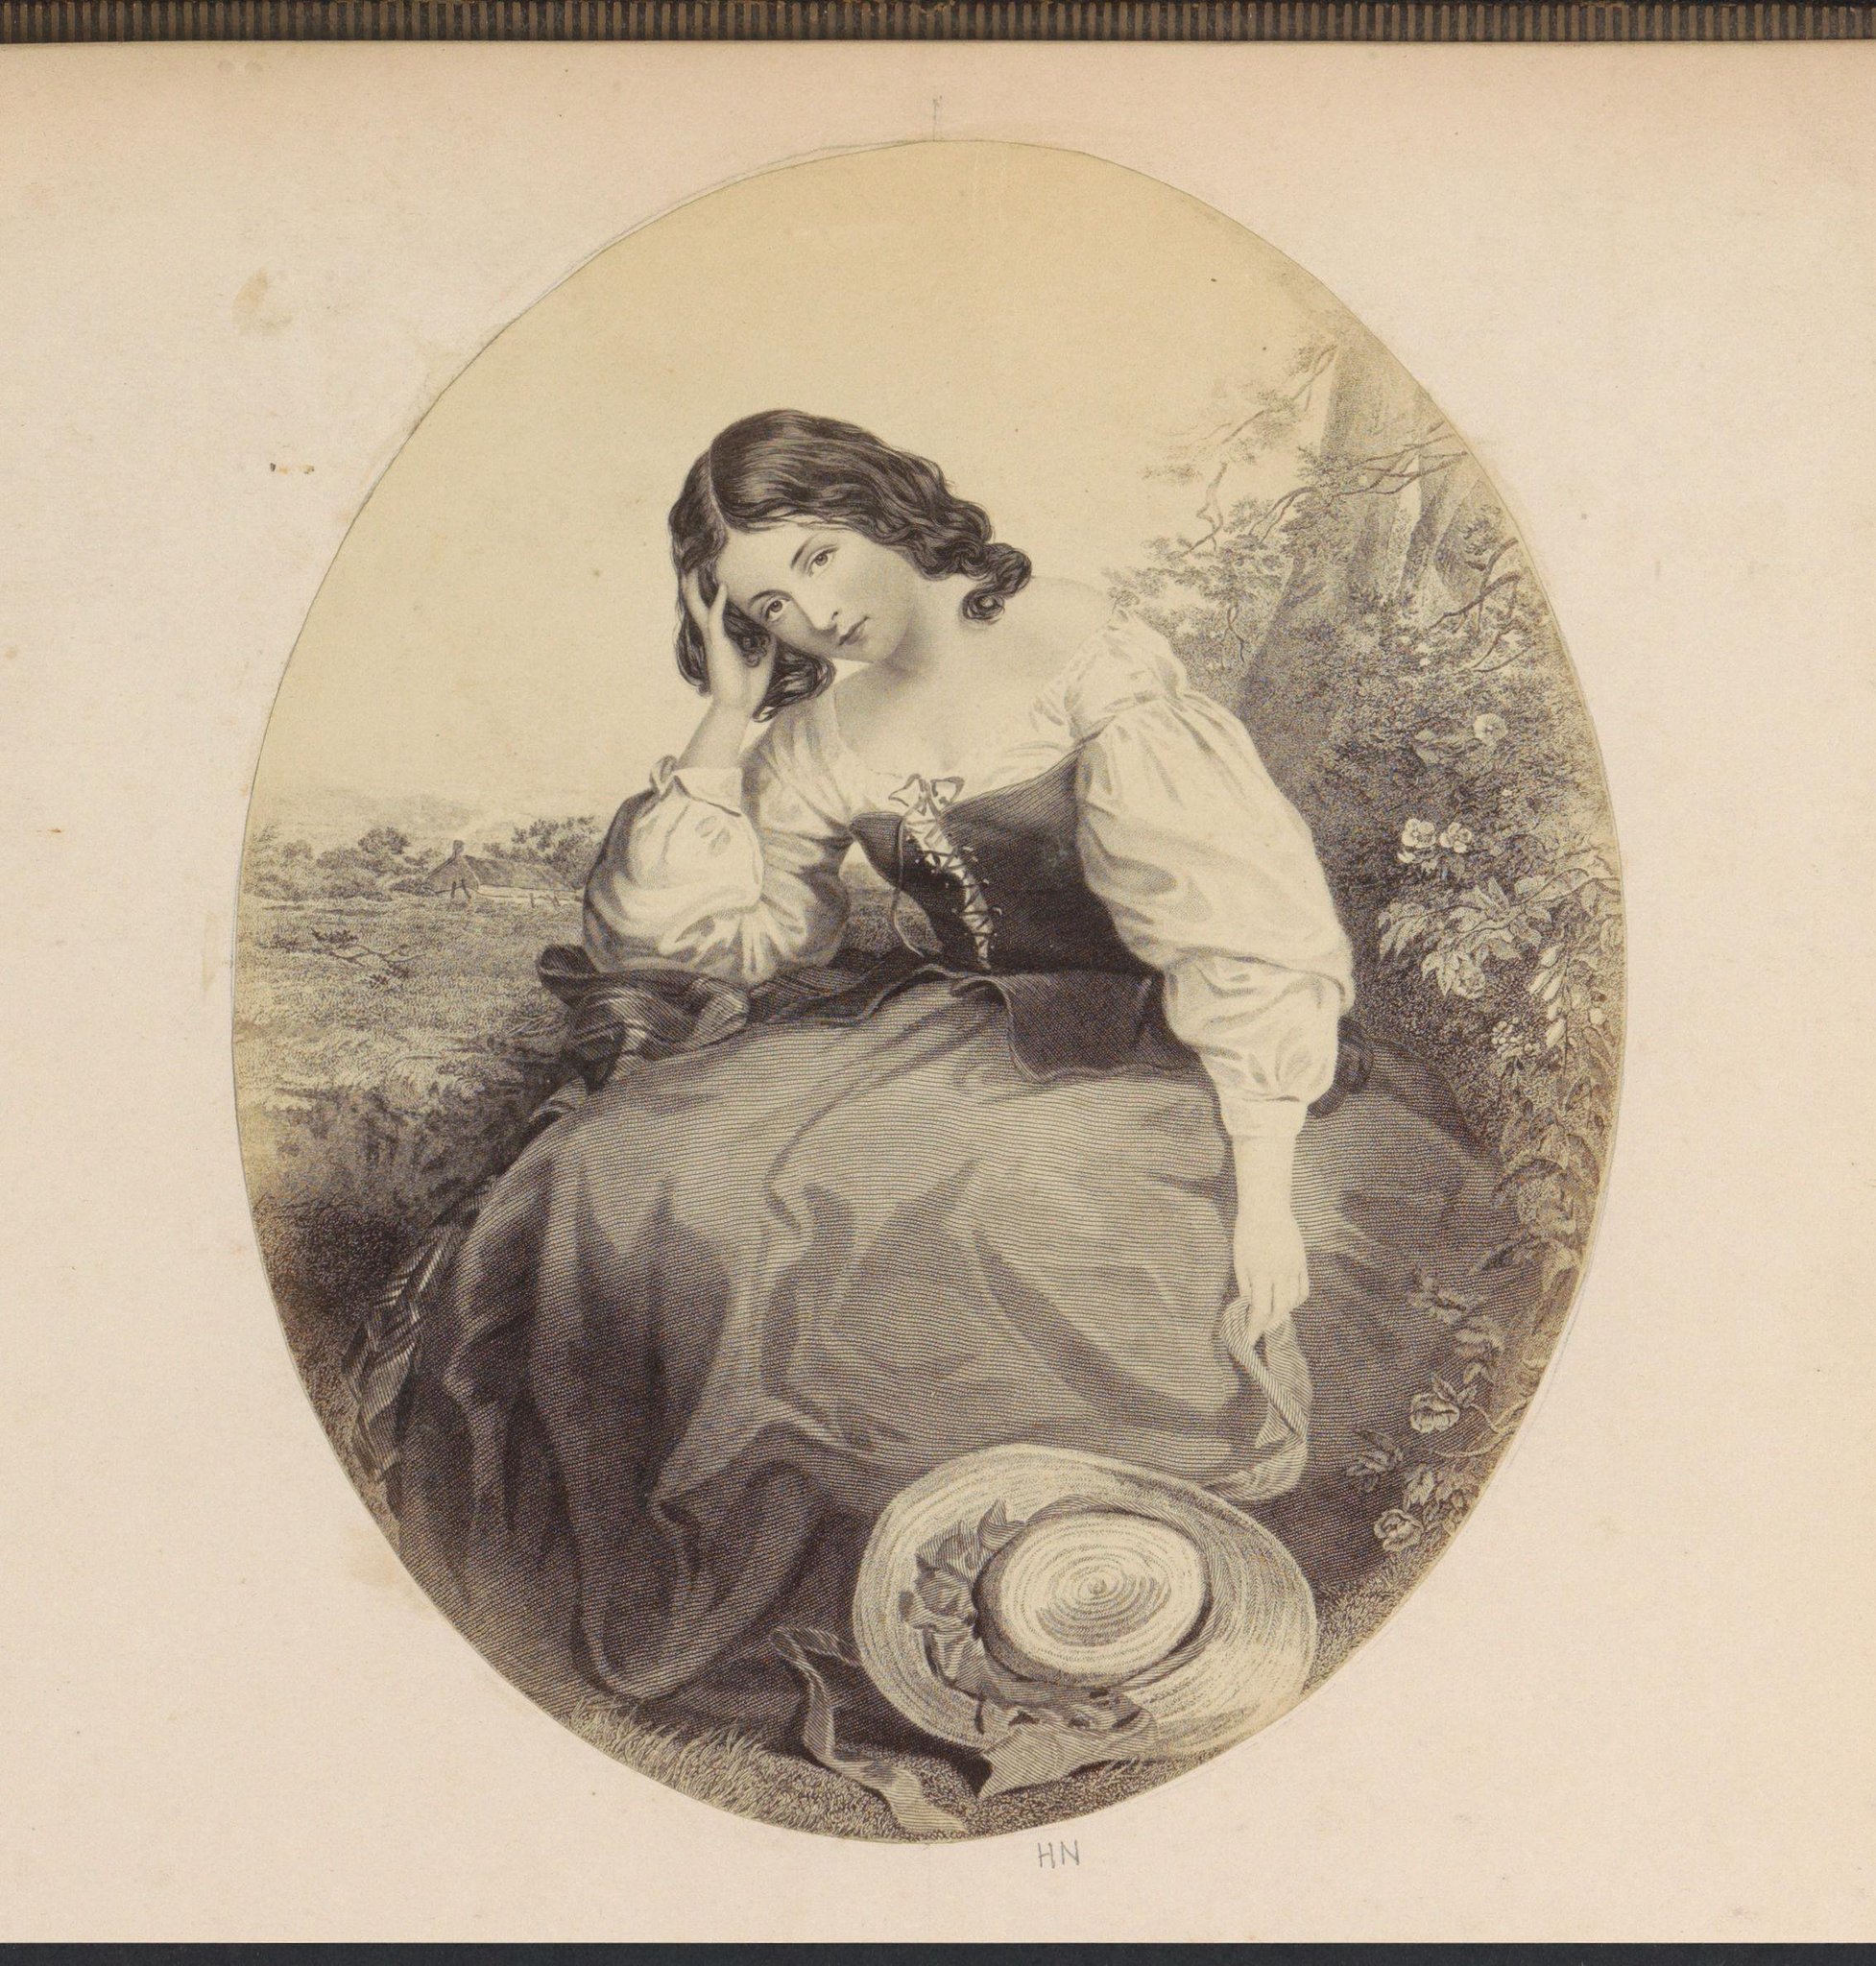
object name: photograph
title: Fotoreproductie van (vermoedelijk) een prent van een jonge vrouw, zittend aan de voet van een boom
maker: Anonymous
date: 1850-1870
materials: paper, photographic support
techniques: albumen print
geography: england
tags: adolescent, young woman, maiden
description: Onderdeel van Album met foto's van bezienswaardigheden en landschappen in Engeland en van kunst.